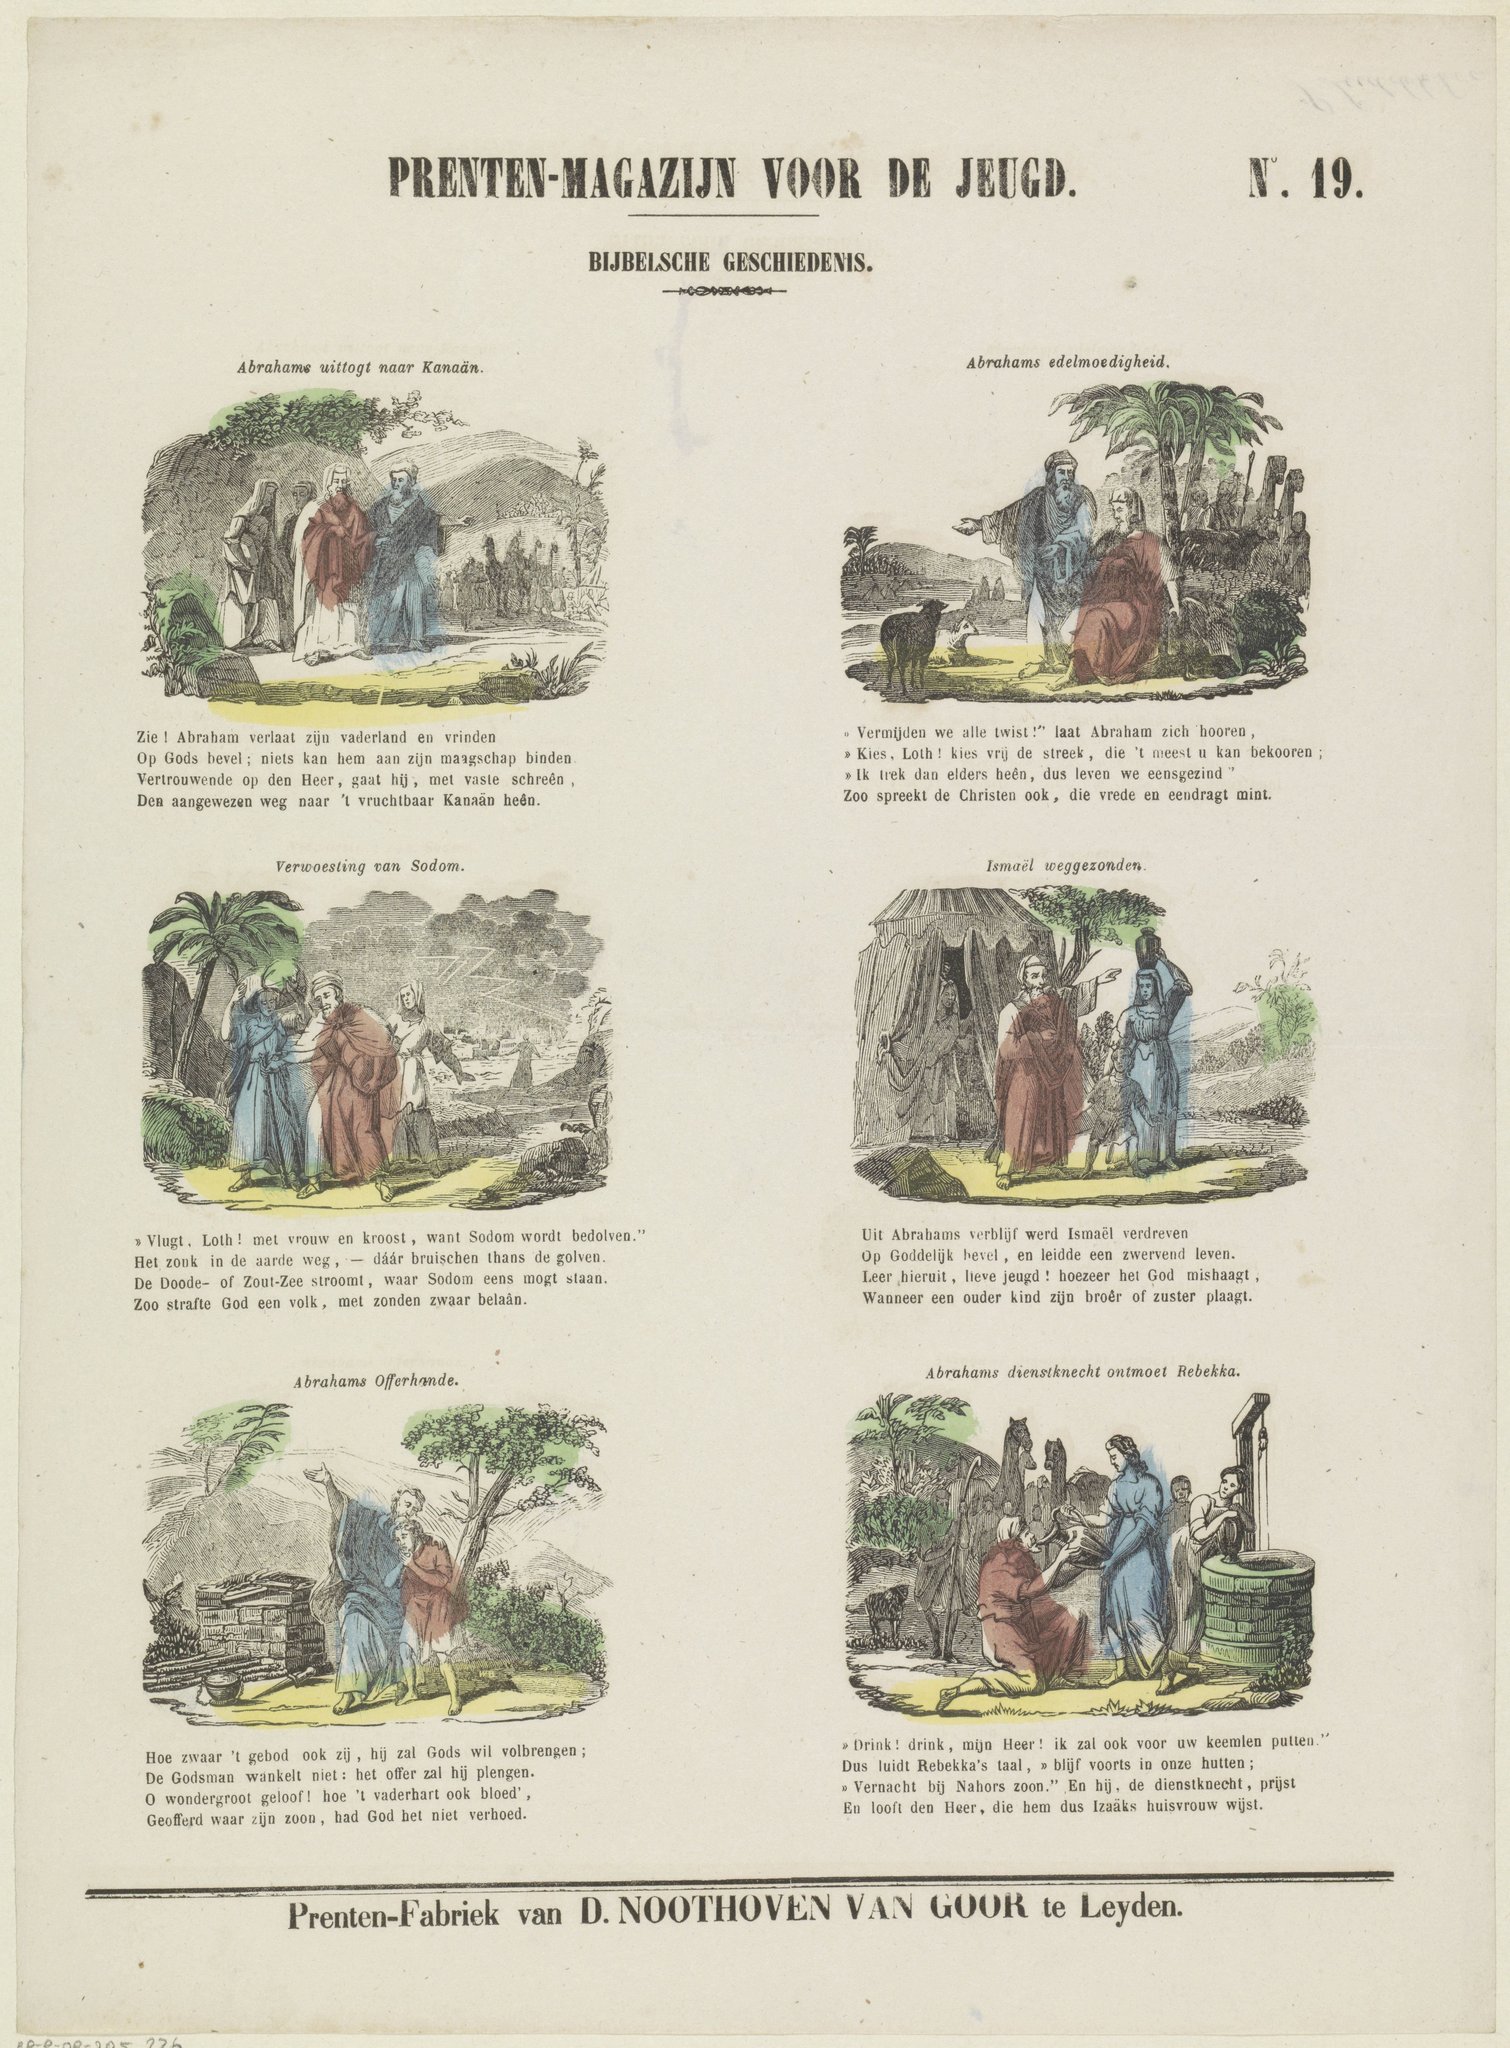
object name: popular print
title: Bijbelsche geschiedenis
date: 1850-1881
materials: paper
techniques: colour, letterpress printing, engraving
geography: leiden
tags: story of abraham, old testament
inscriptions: collector's mark: Lugt 2760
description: Blad met 6 voorstellingen van verhalen uit het Oude Testament, zoals de tocht van Abraham naar Kanaän en Abrahams dienstknecht ontmoet Rebekka bij de bron. Boven elke voorstelling een titel en onder elke voorstelling een vierregelig vers. Genummerd rechtsboven: No. 19.